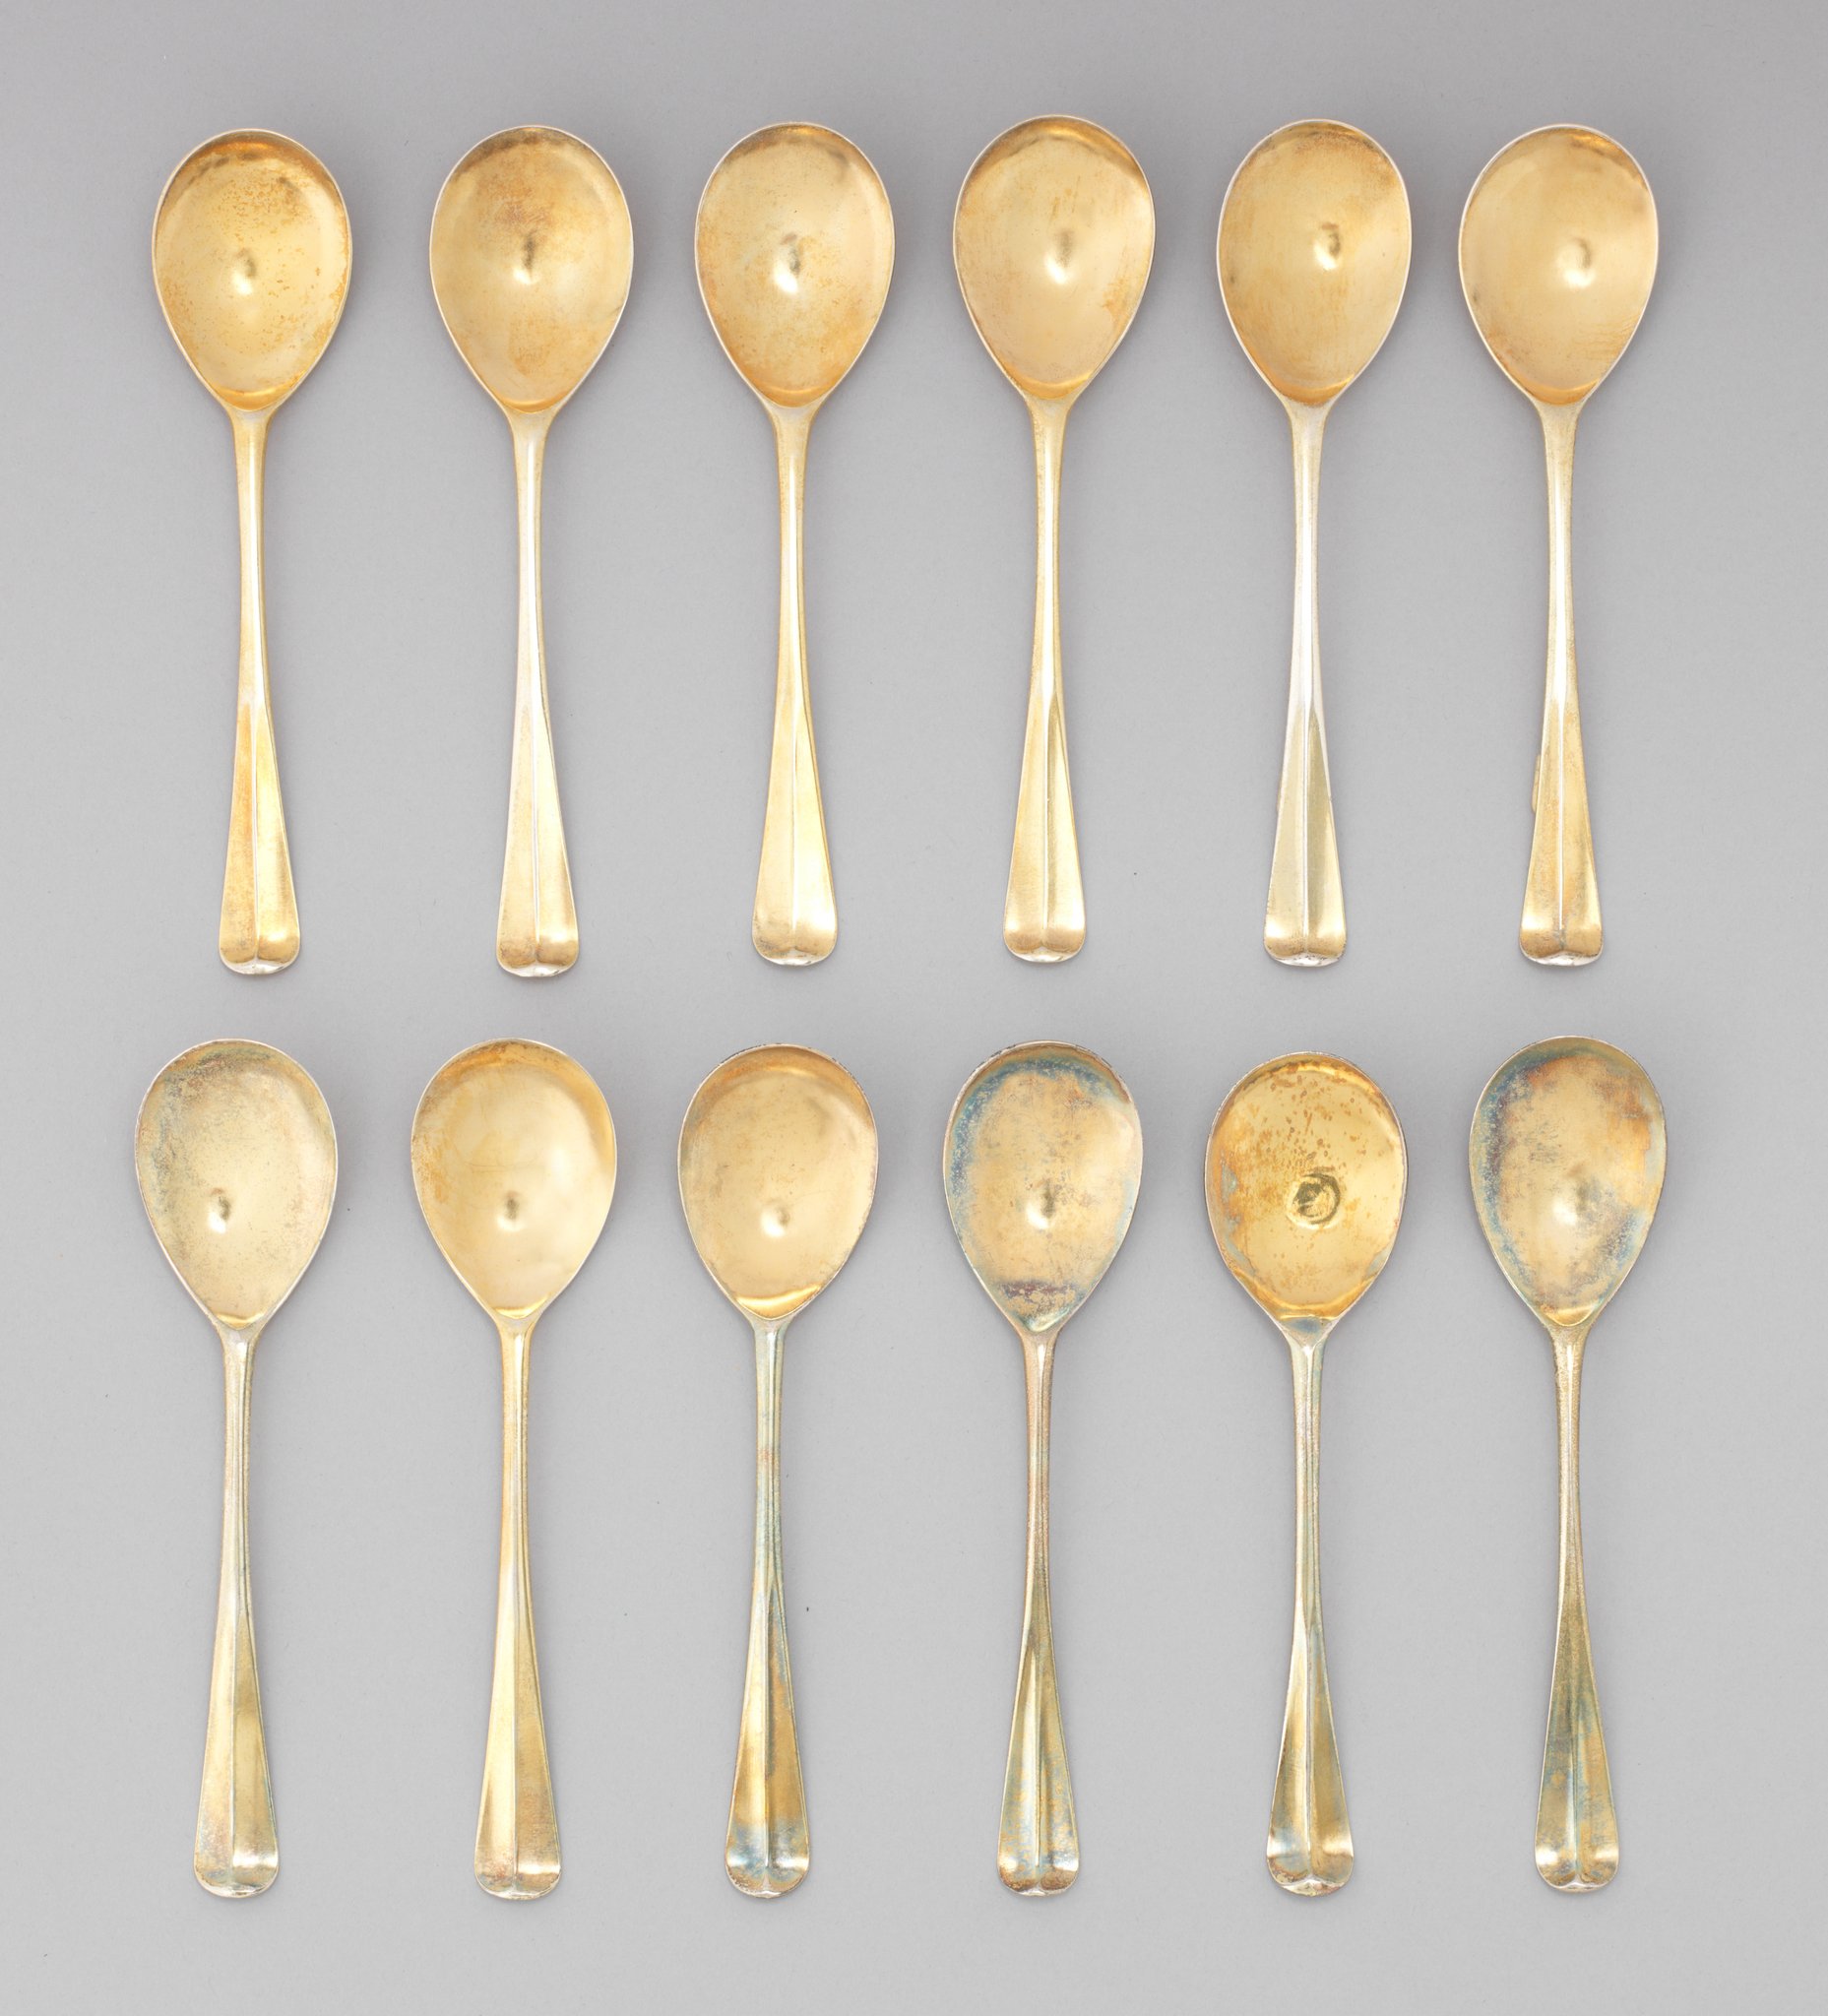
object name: dessert spoon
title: Two dessert spoons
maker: hester bateman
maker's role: maker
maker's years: 1761-1790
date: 1778-1779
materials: silver gilt